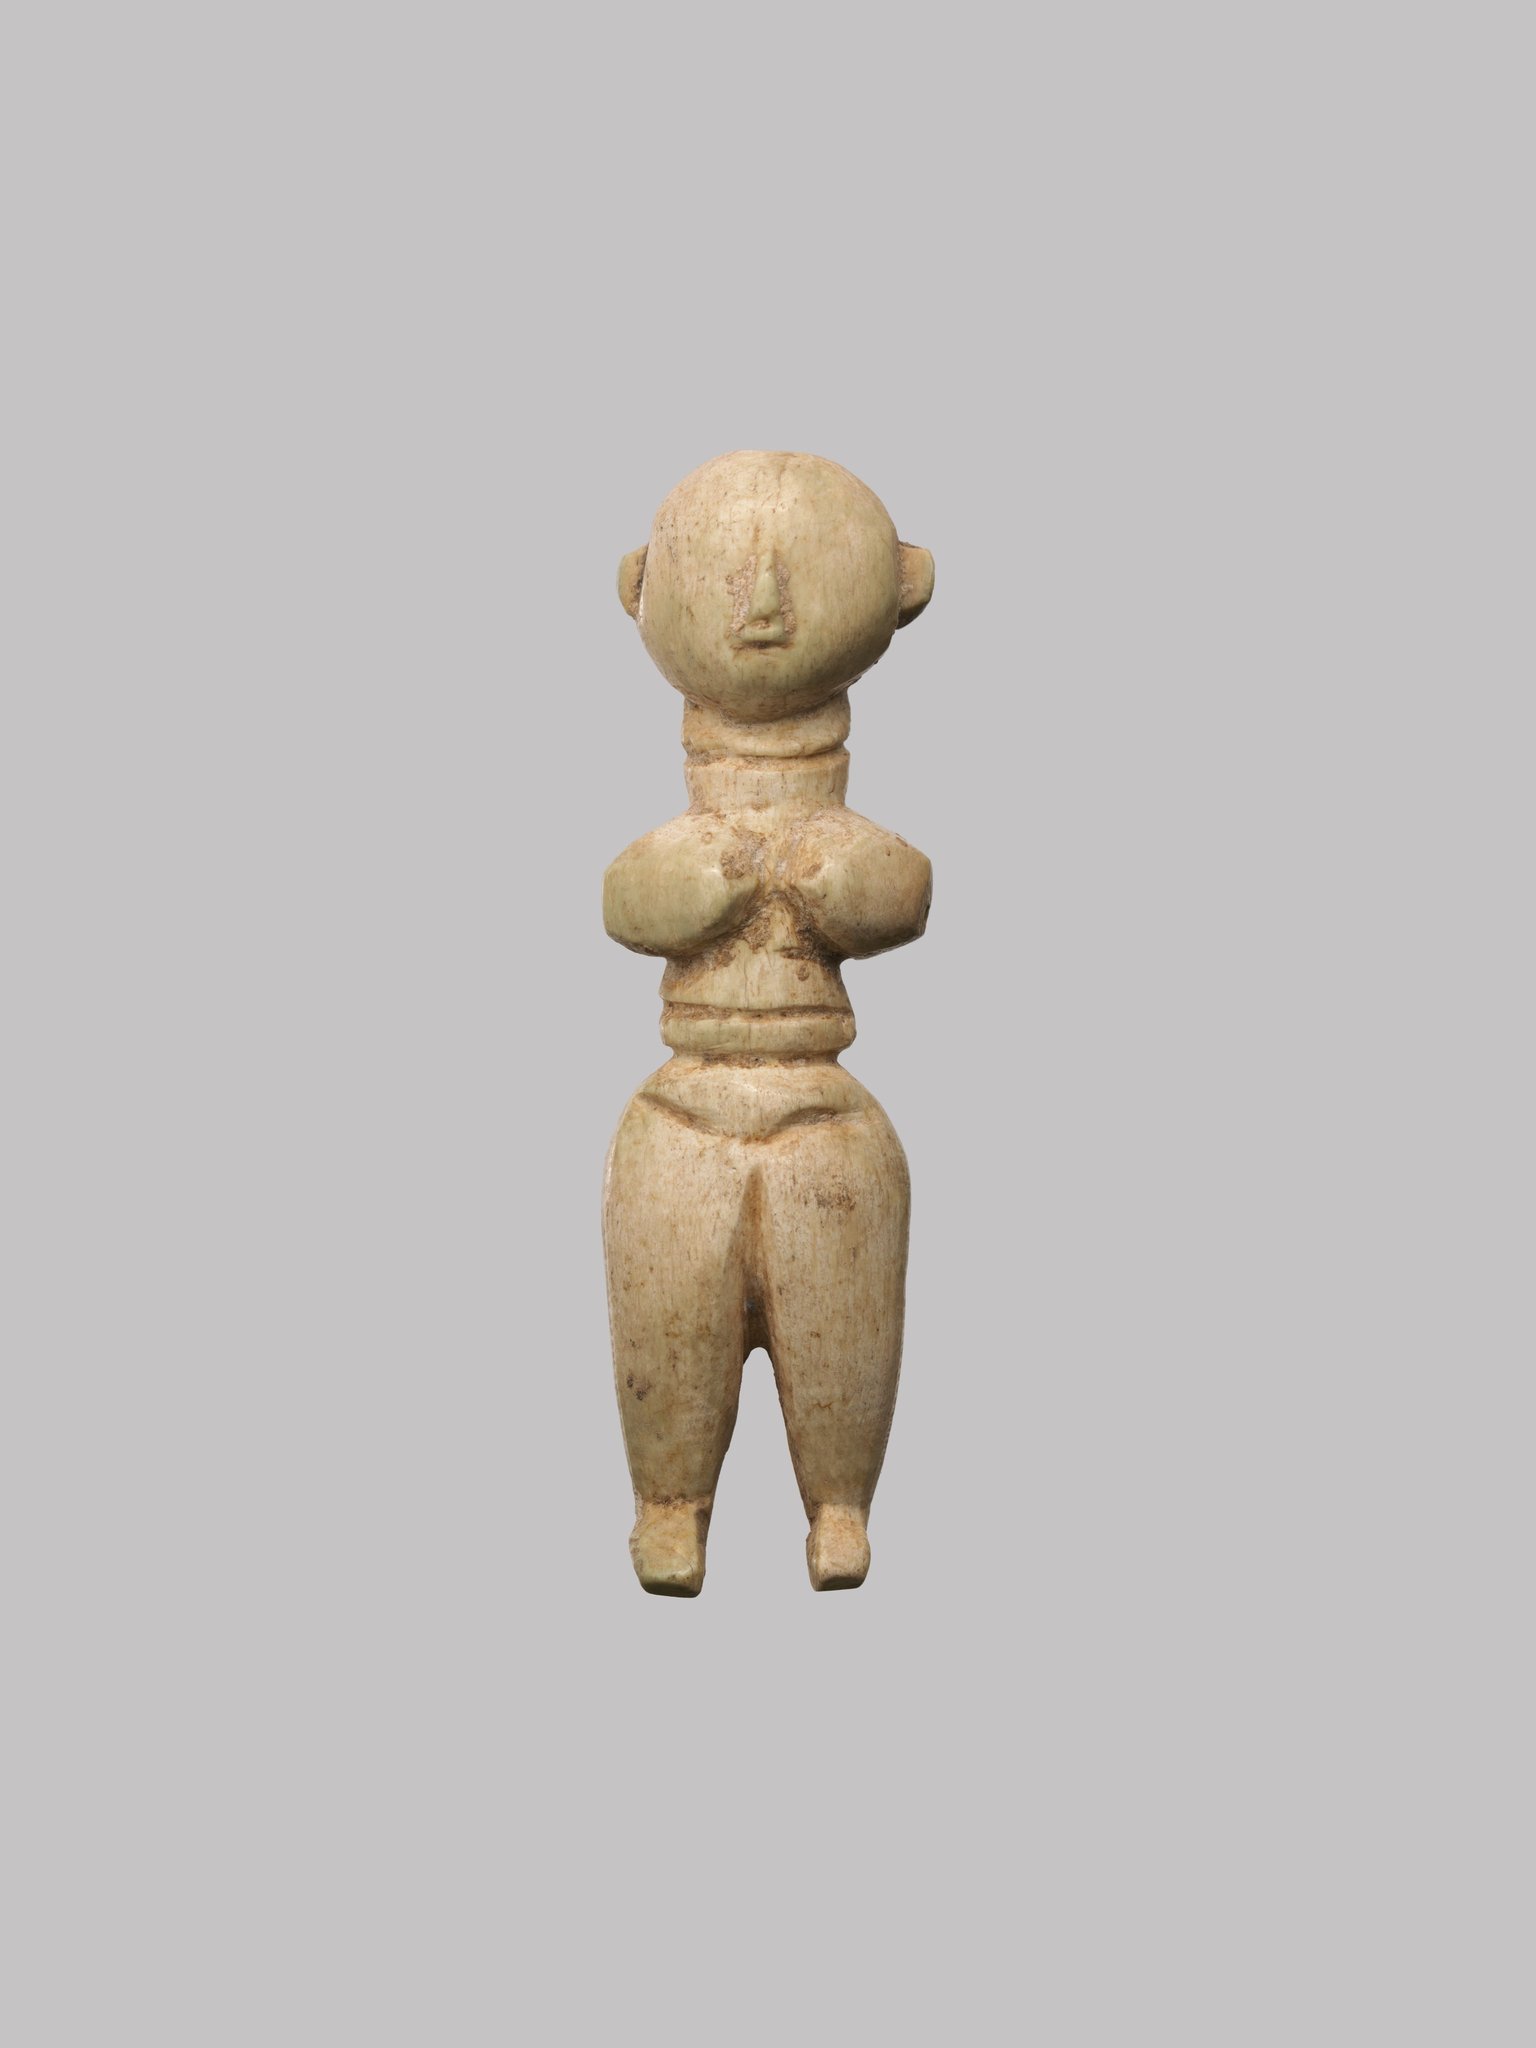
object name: figure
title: Female Fertility (?) Figure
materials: bone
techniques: carving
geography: iran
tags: goddess